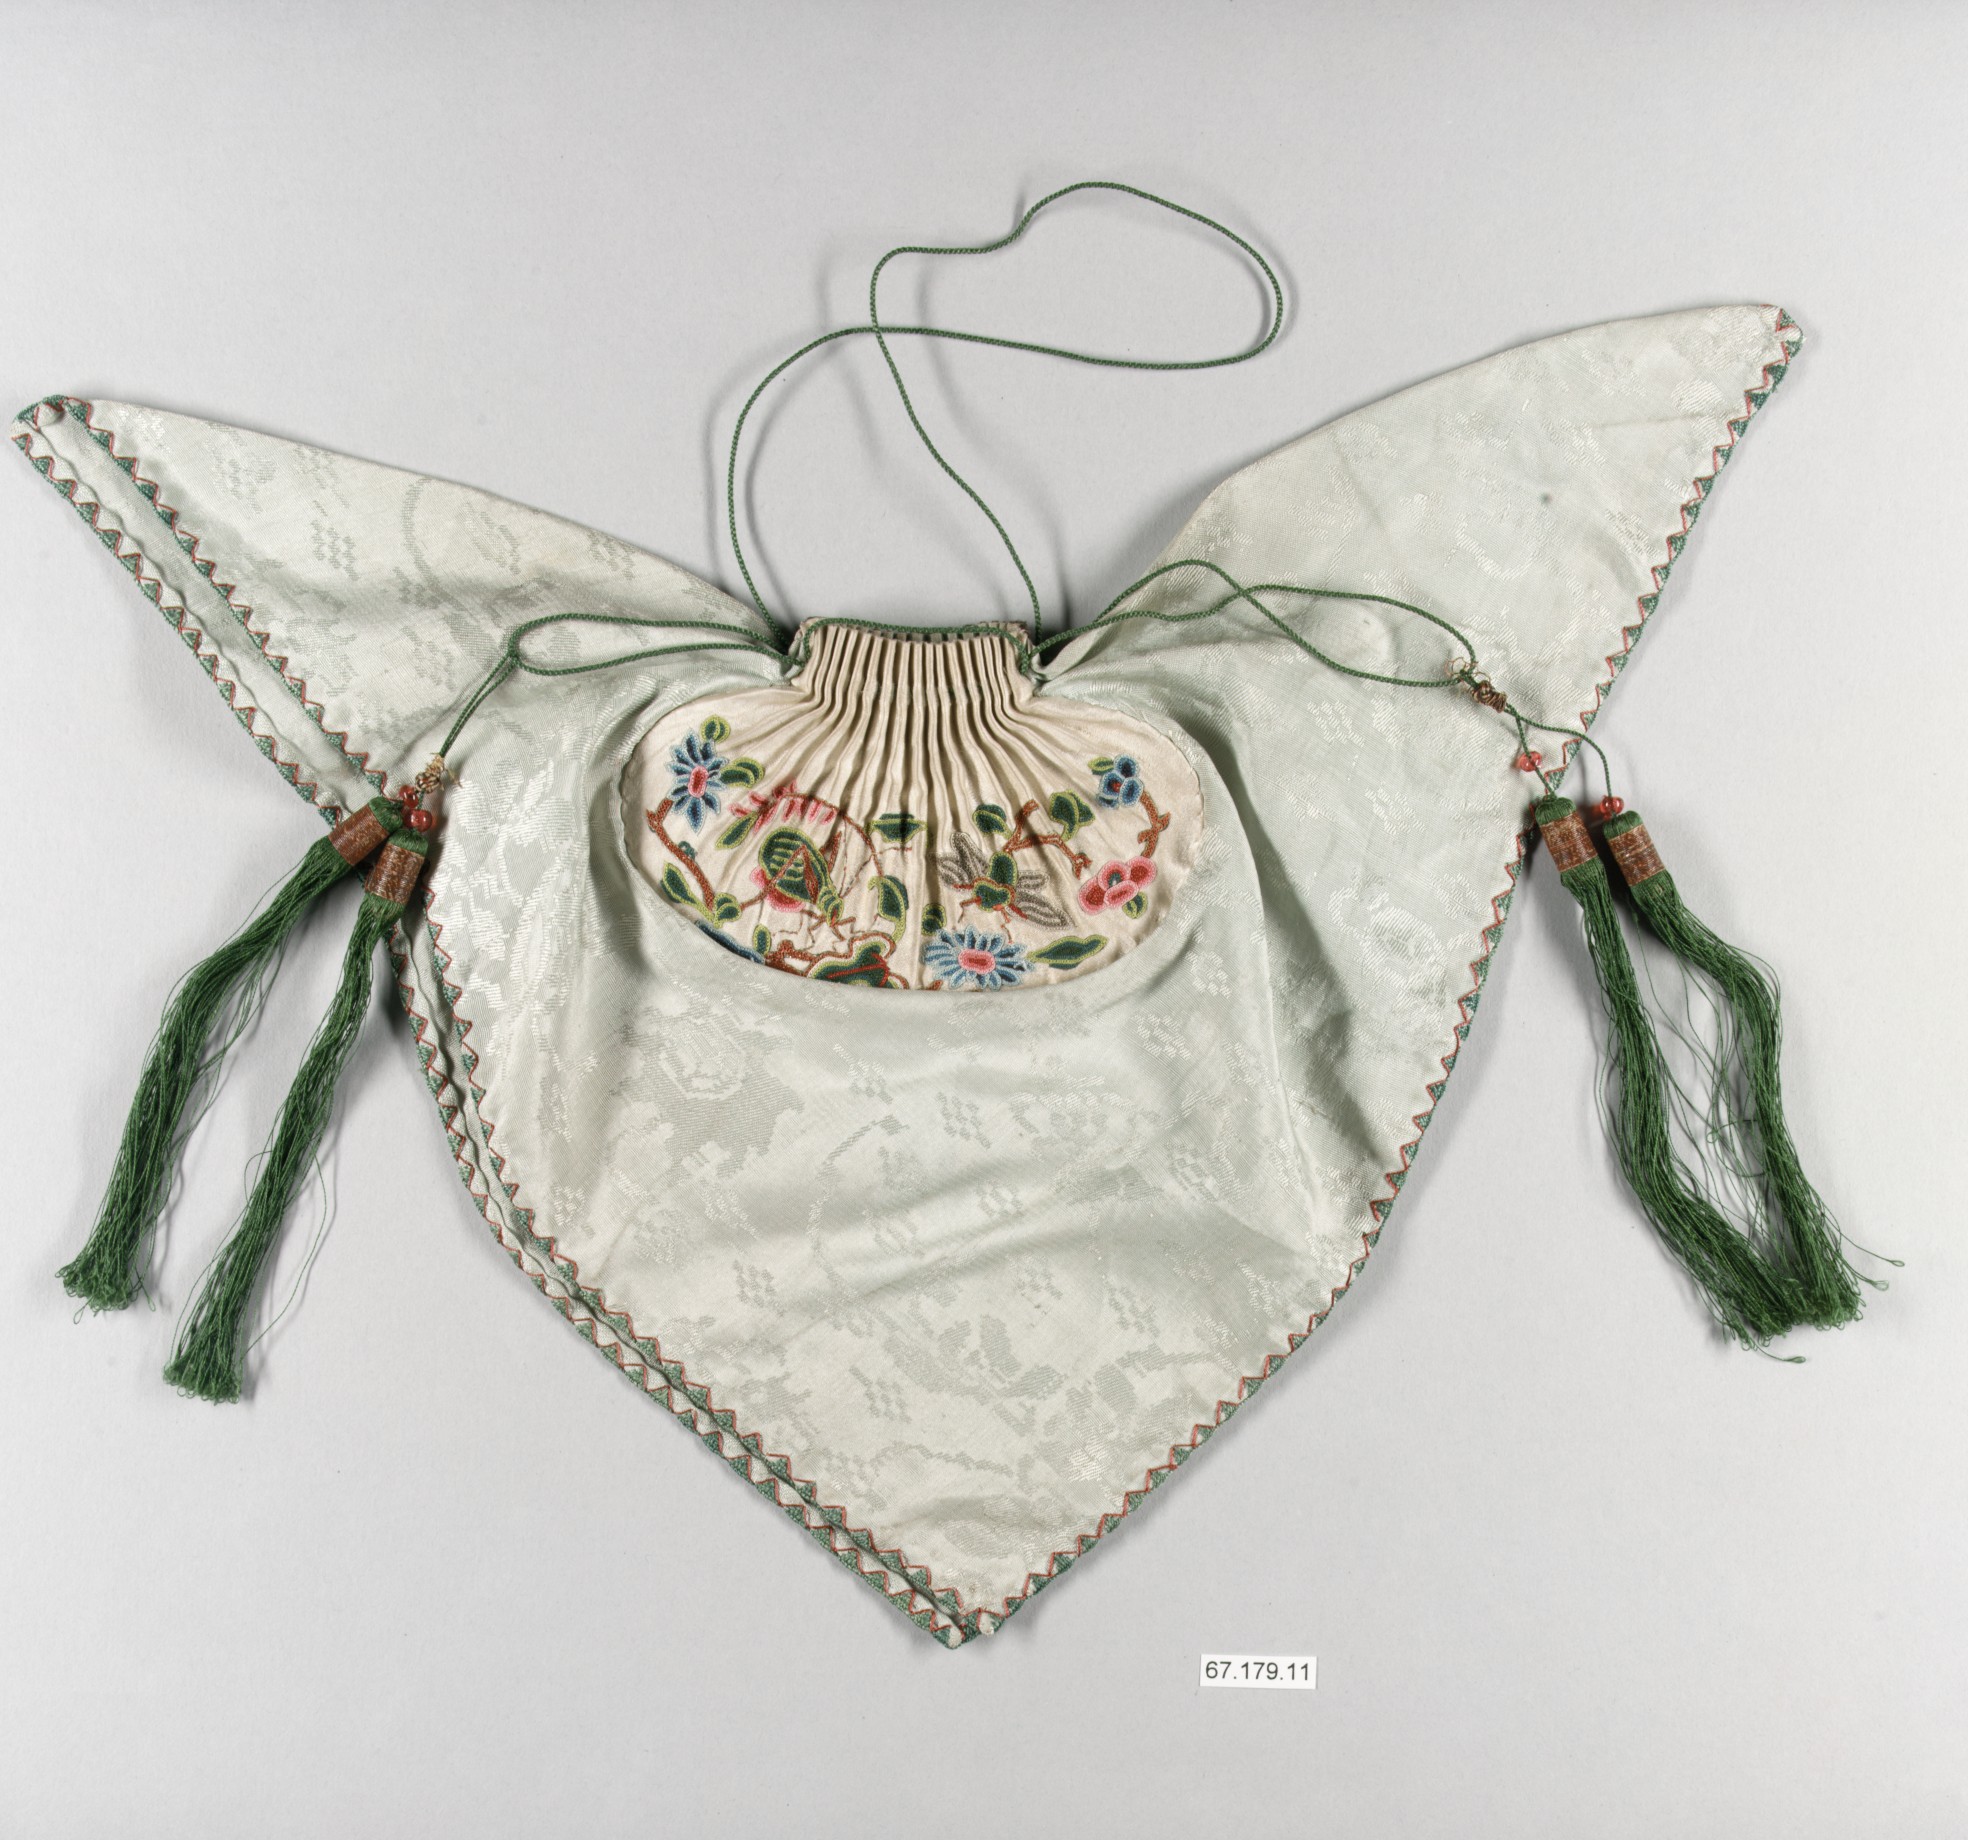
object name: purse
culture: chinese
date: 1801-1900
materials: silk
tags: insects,flowers